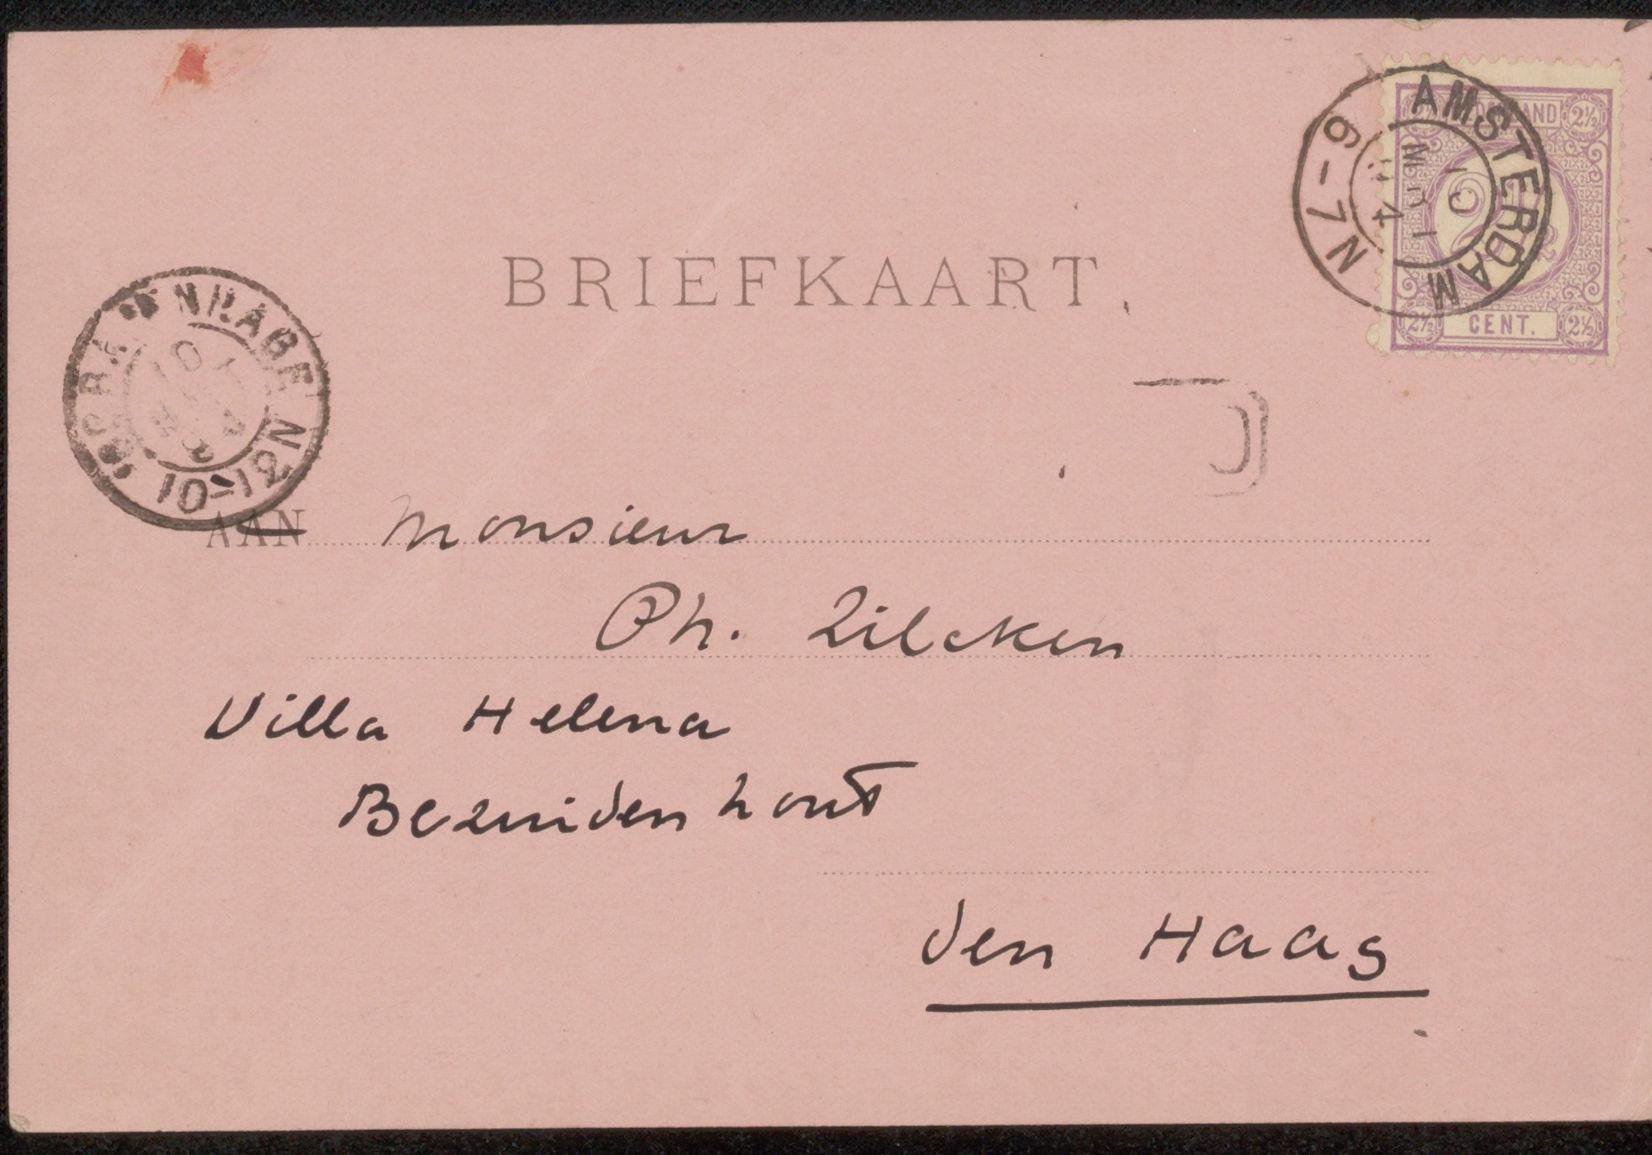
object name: postcard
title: Briefkaart aan Philip Zilcken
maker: richard nicolaüs roland holst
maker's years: 1868-1938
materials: cardboard, ink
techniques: pen, writing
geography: amsterdam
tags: the hague, painter, draughtsman, philip zilcken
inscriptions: collector's mark: ‘RPK’